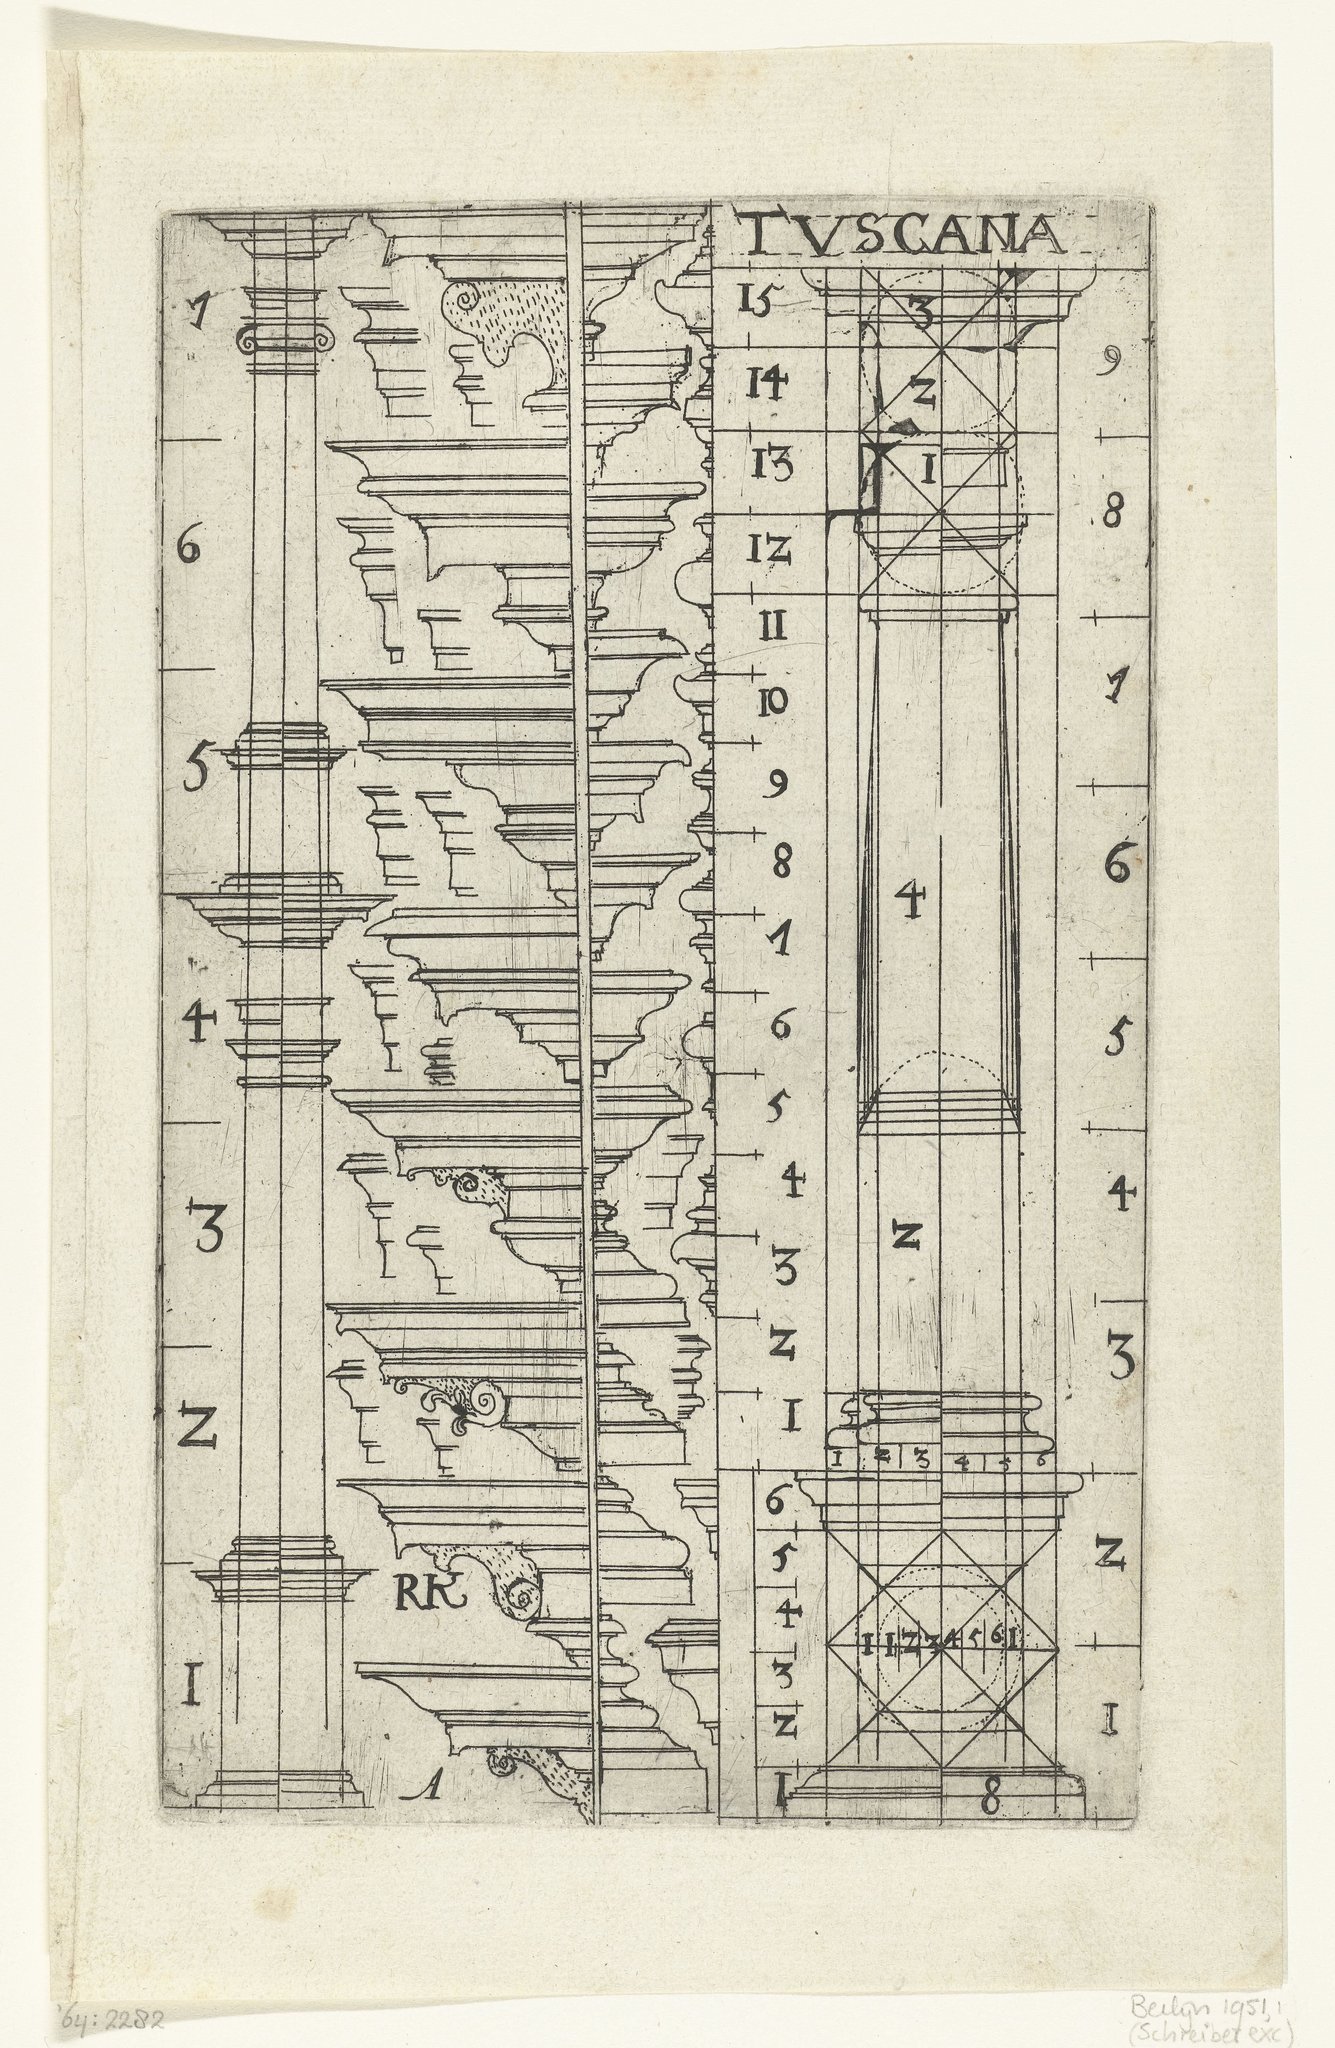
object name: print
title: Tvscana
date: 1622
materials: paper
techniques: etching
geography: paris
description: Links twee zuilen onder elkaar en verschillende hoofdgestellen, rechts een Toscaanse zuil op een voetstuk. Blad A uit tweede editie van serie, bestaande uit 24 bladen. De volgorde van bladen is gewijzigd in deze editie, de nummers zijn grotendeels verwijderd en vervangen door letters en er zijn vier bladen minder.